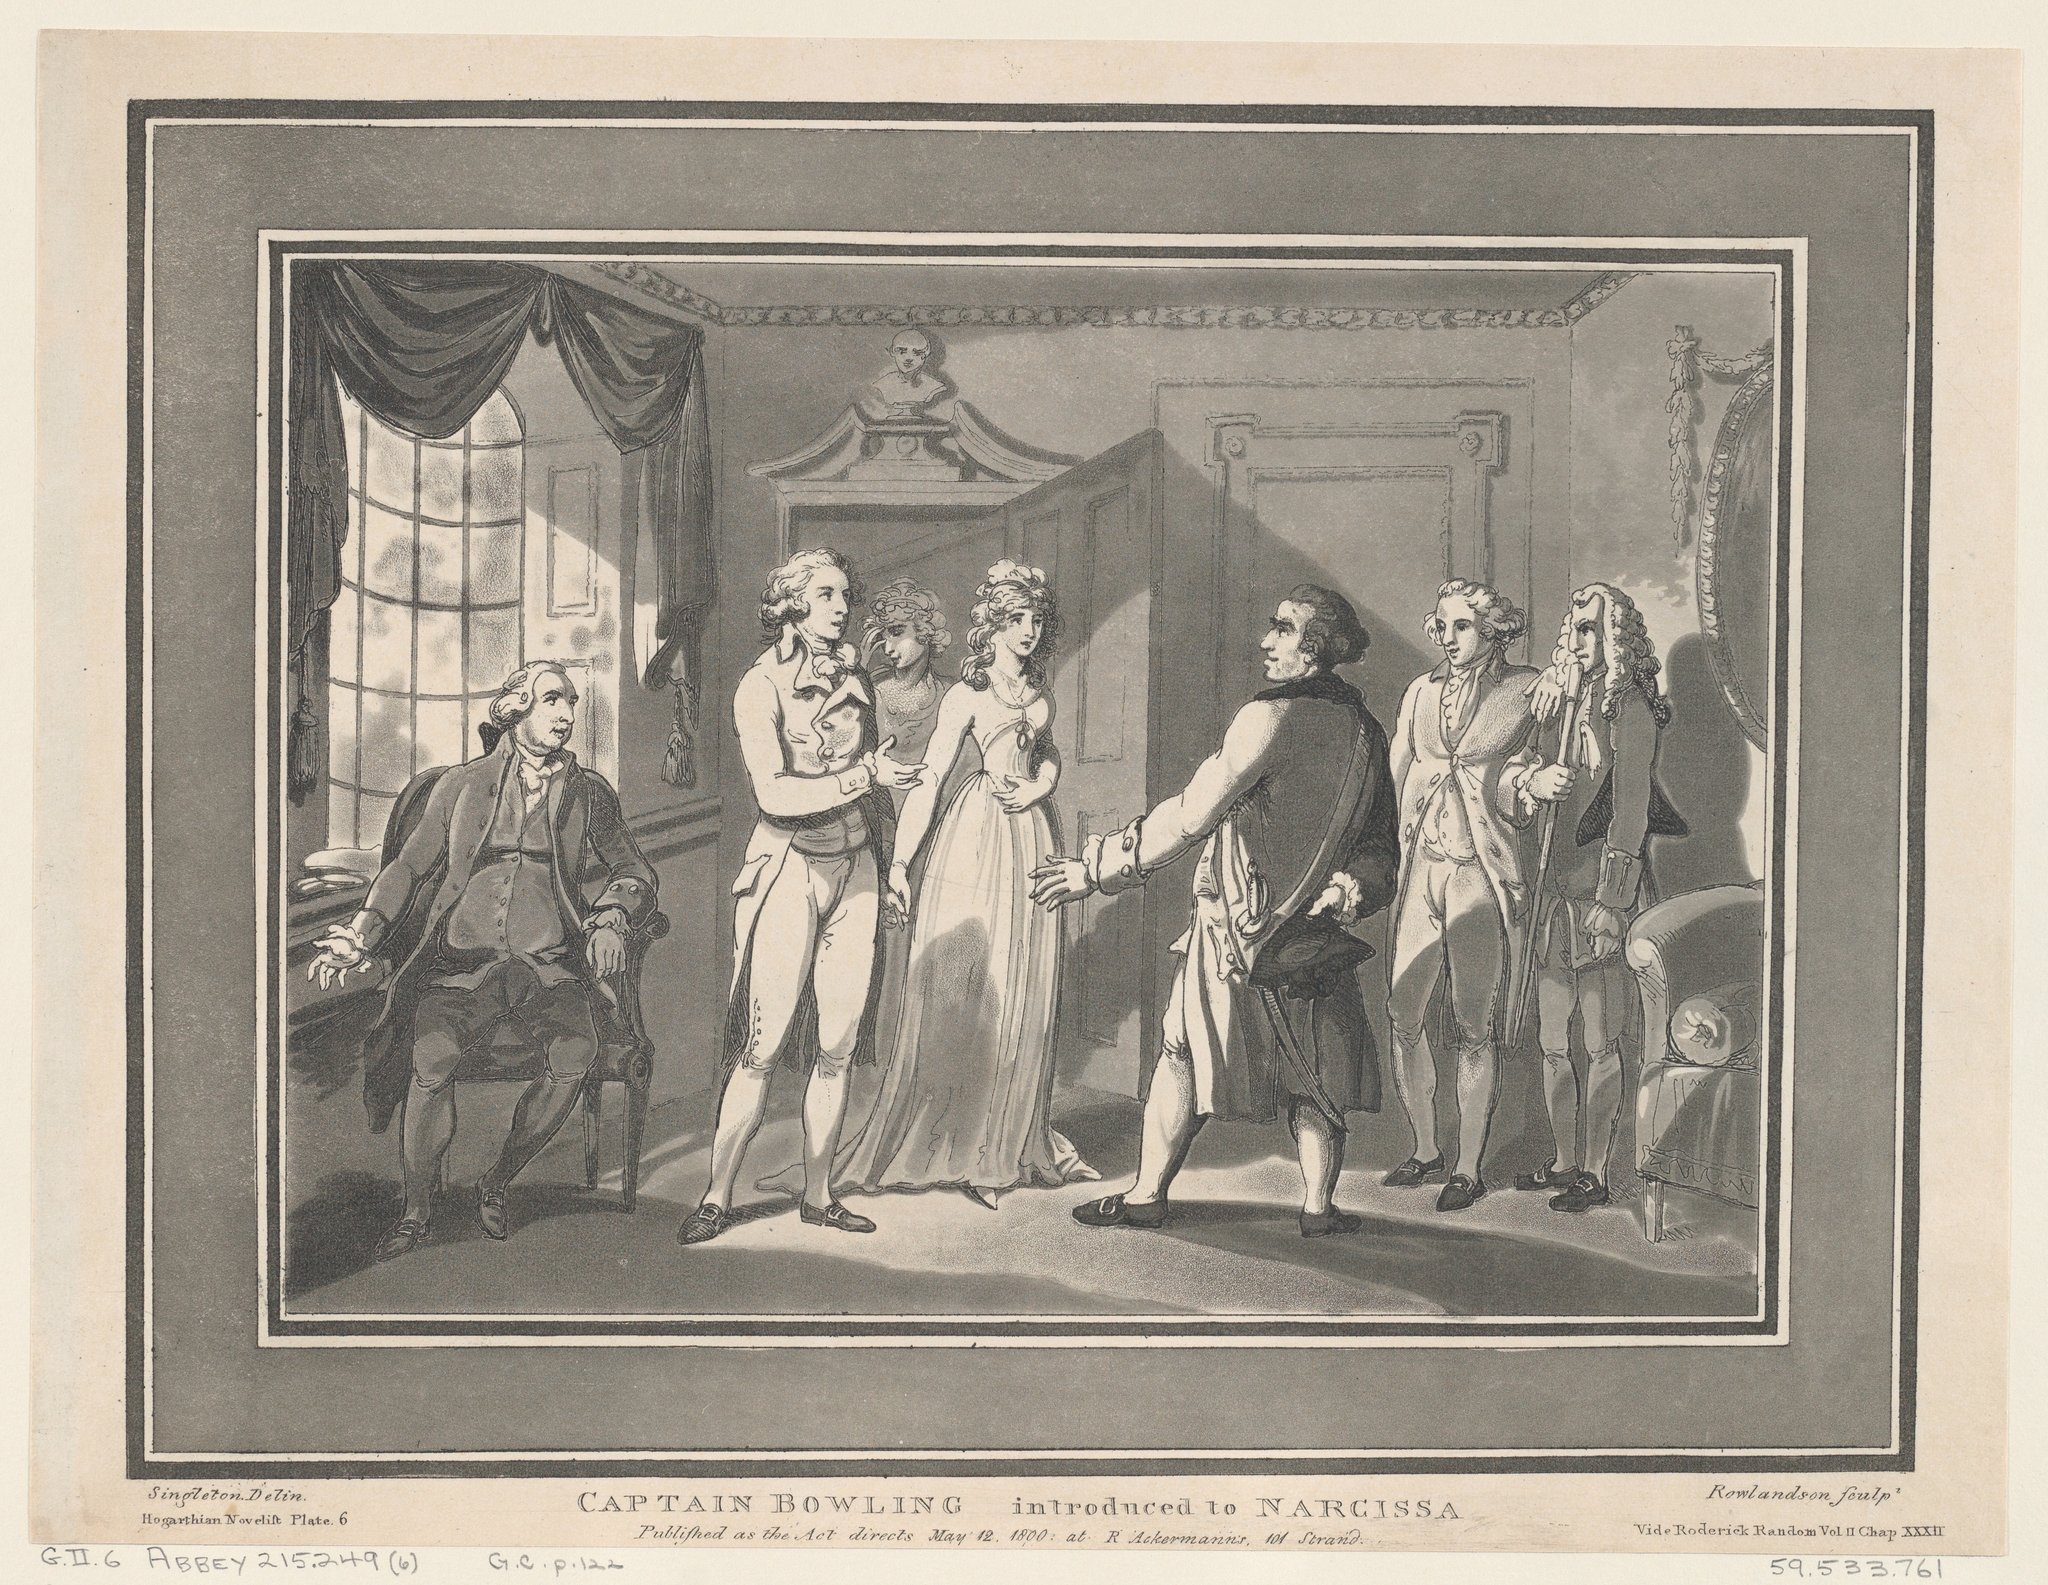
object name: print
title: Captain Bowling introduced to Narcissa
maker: thomas rowlandson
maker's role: artist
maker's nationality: british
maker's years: 1757-1827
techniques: aquatint, etching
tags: men